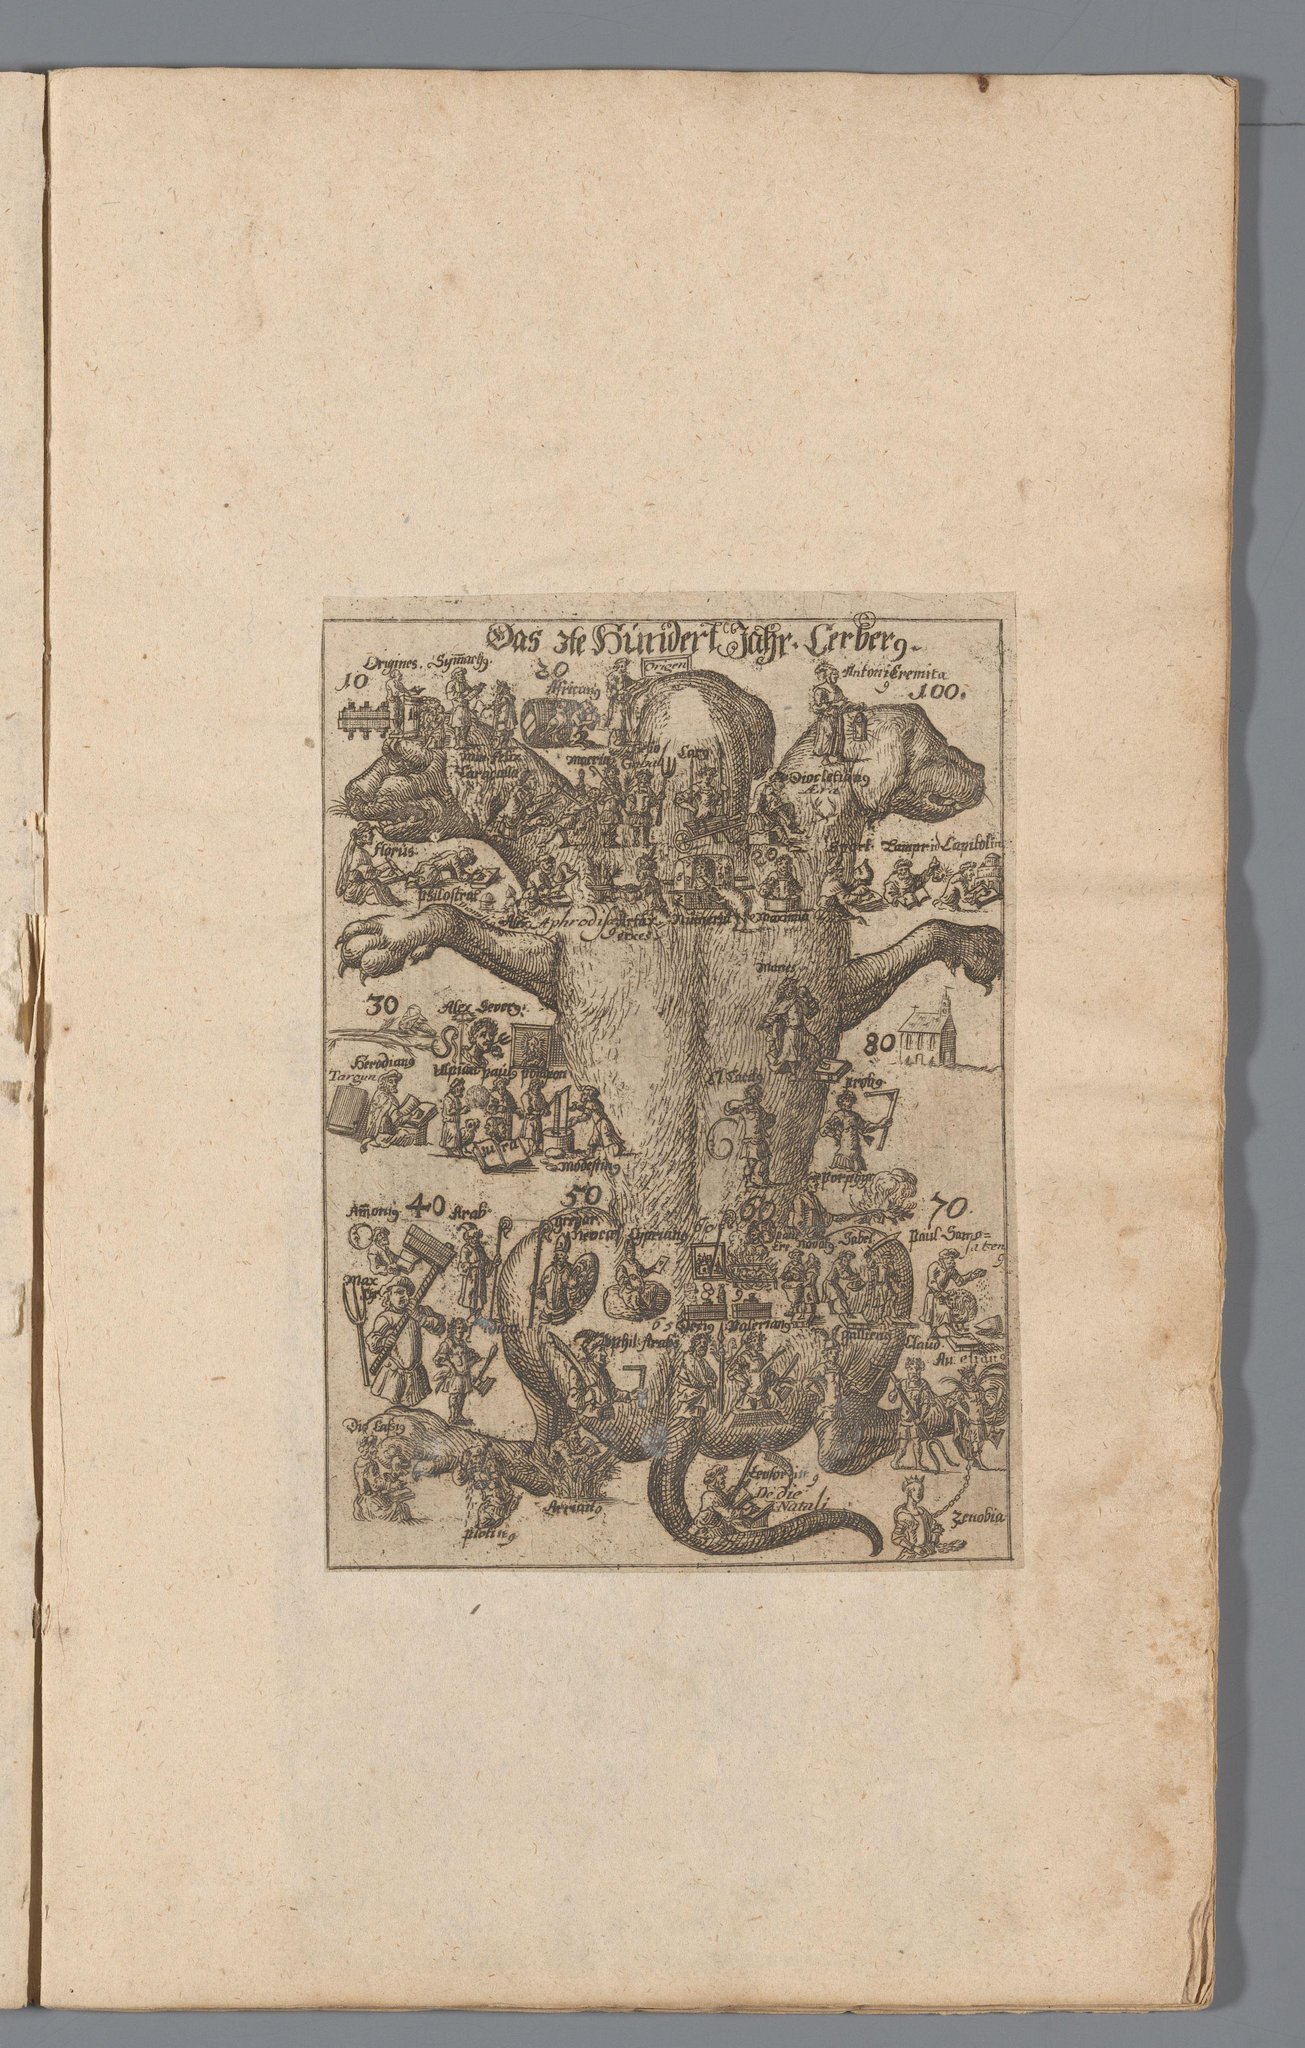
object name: print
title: Derde eeuw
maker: Anonymous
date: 1667-1672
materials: paper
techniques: engraving, etching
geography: germany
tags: cerberus, the three- or many-headed dog; 'cerbero' (ripa)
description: Prenten afkomstig uit een editie van: Johannes Buno, Historische Bilder/ Darinnen Idea Historiae Universalis : Eine kurtze Summarische Abbildung Der fürnehmsten Geist- und Weltlichen Geschichte durch die vier Monarchien ..., eerst uitgegeven door Bartold Elers in Lüneburg in 1672.